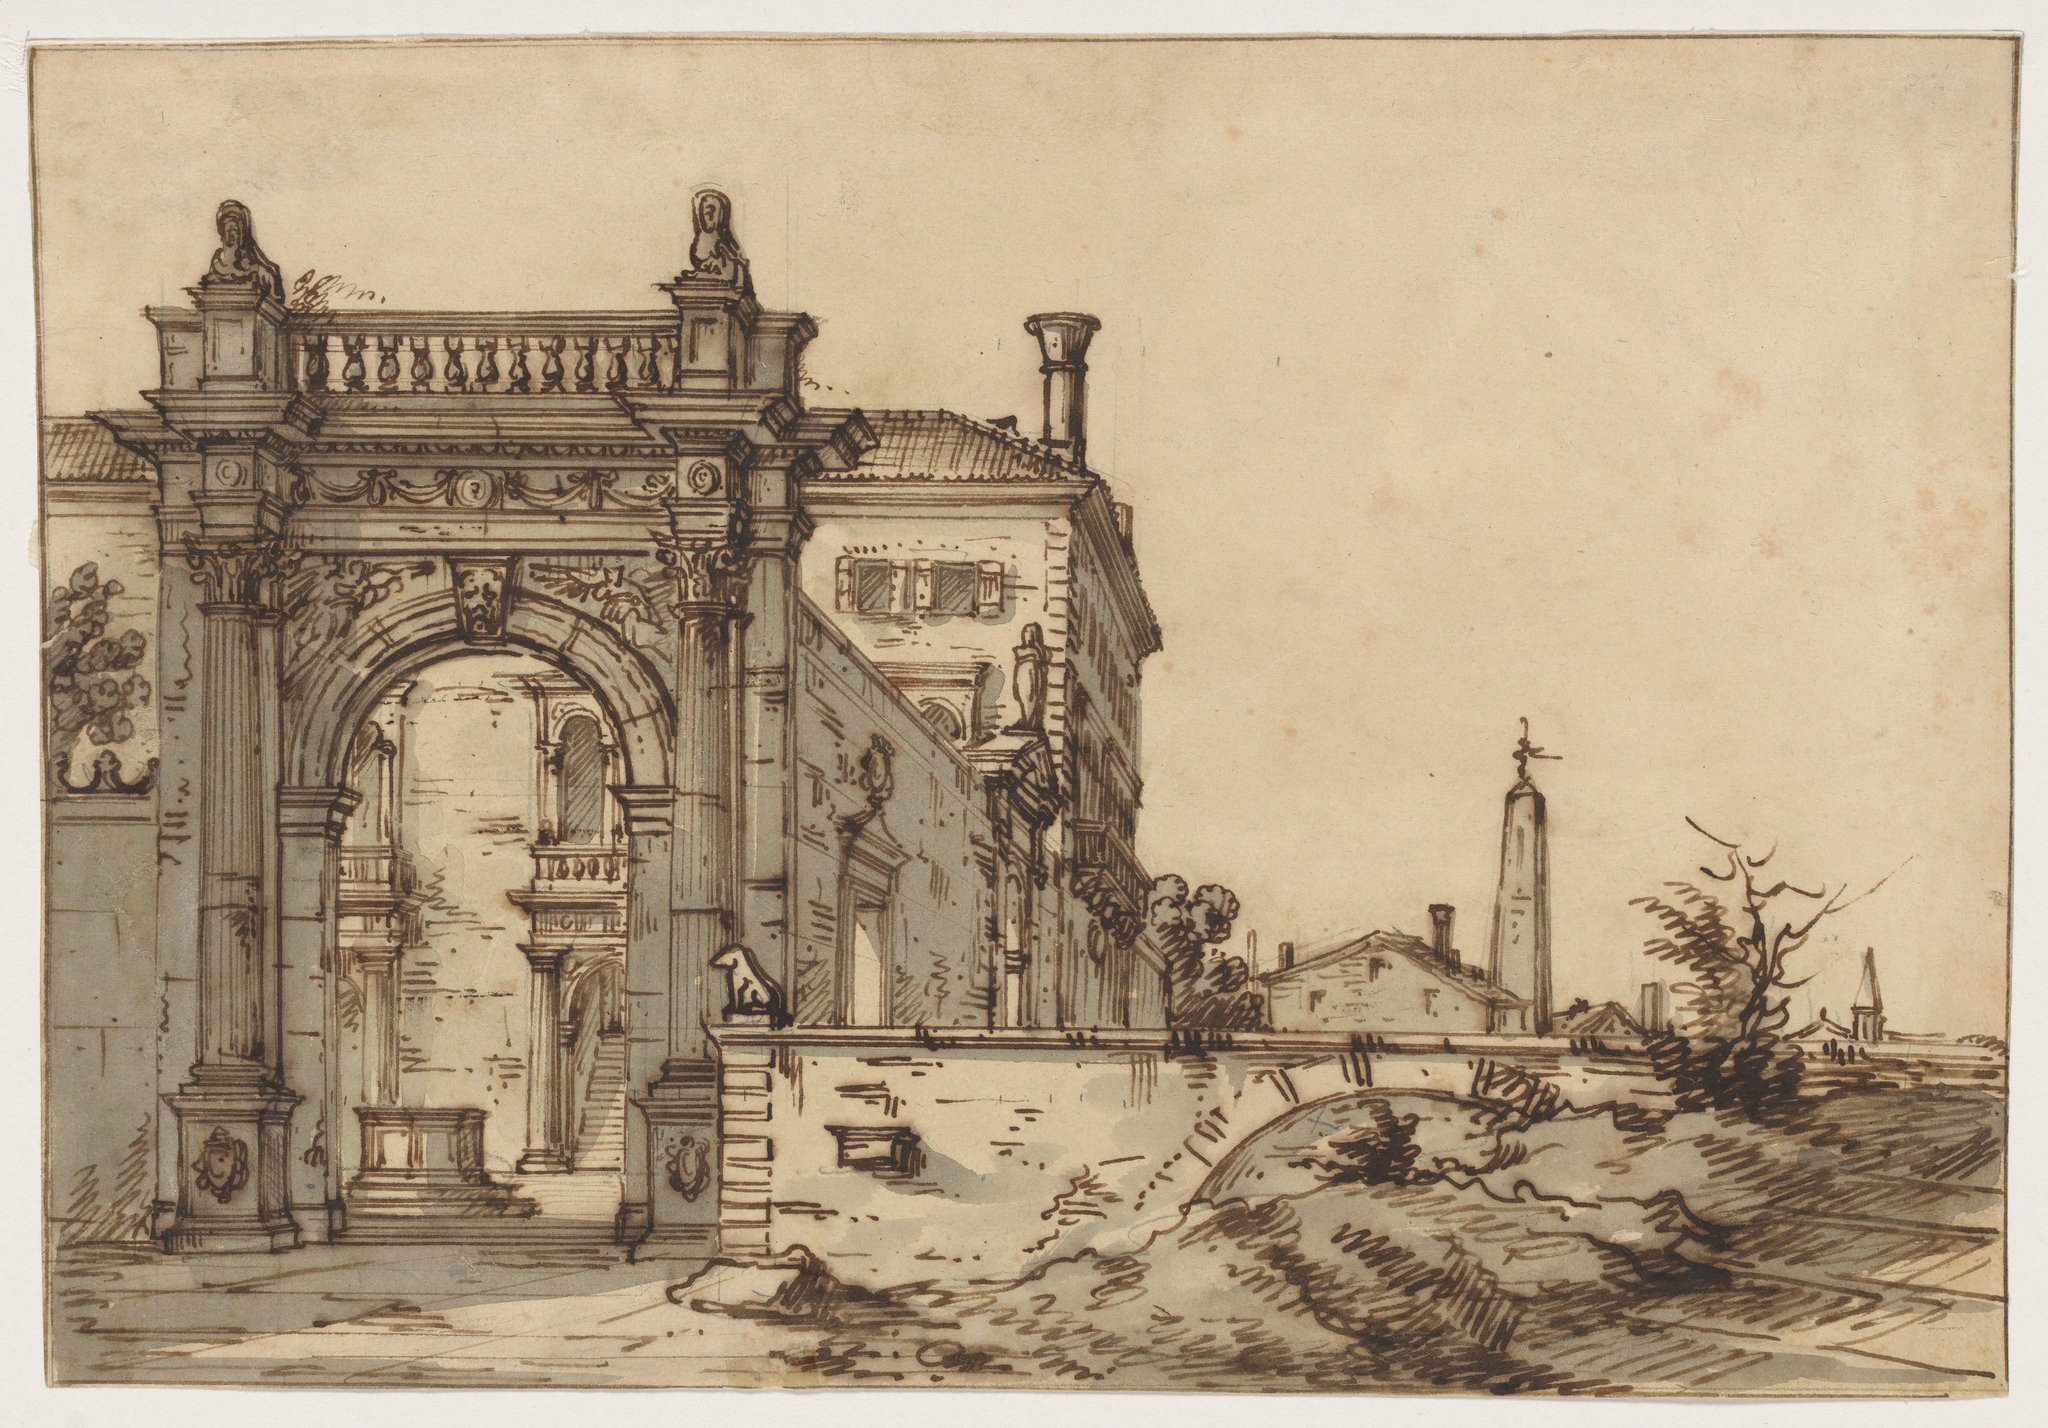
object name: drawing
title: A Venetian Villa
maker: bernardo bellotto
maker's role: artist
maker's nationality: italian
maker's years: 1722-1780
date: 1741-1780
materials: ink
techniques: pen, wash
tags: houses,venice